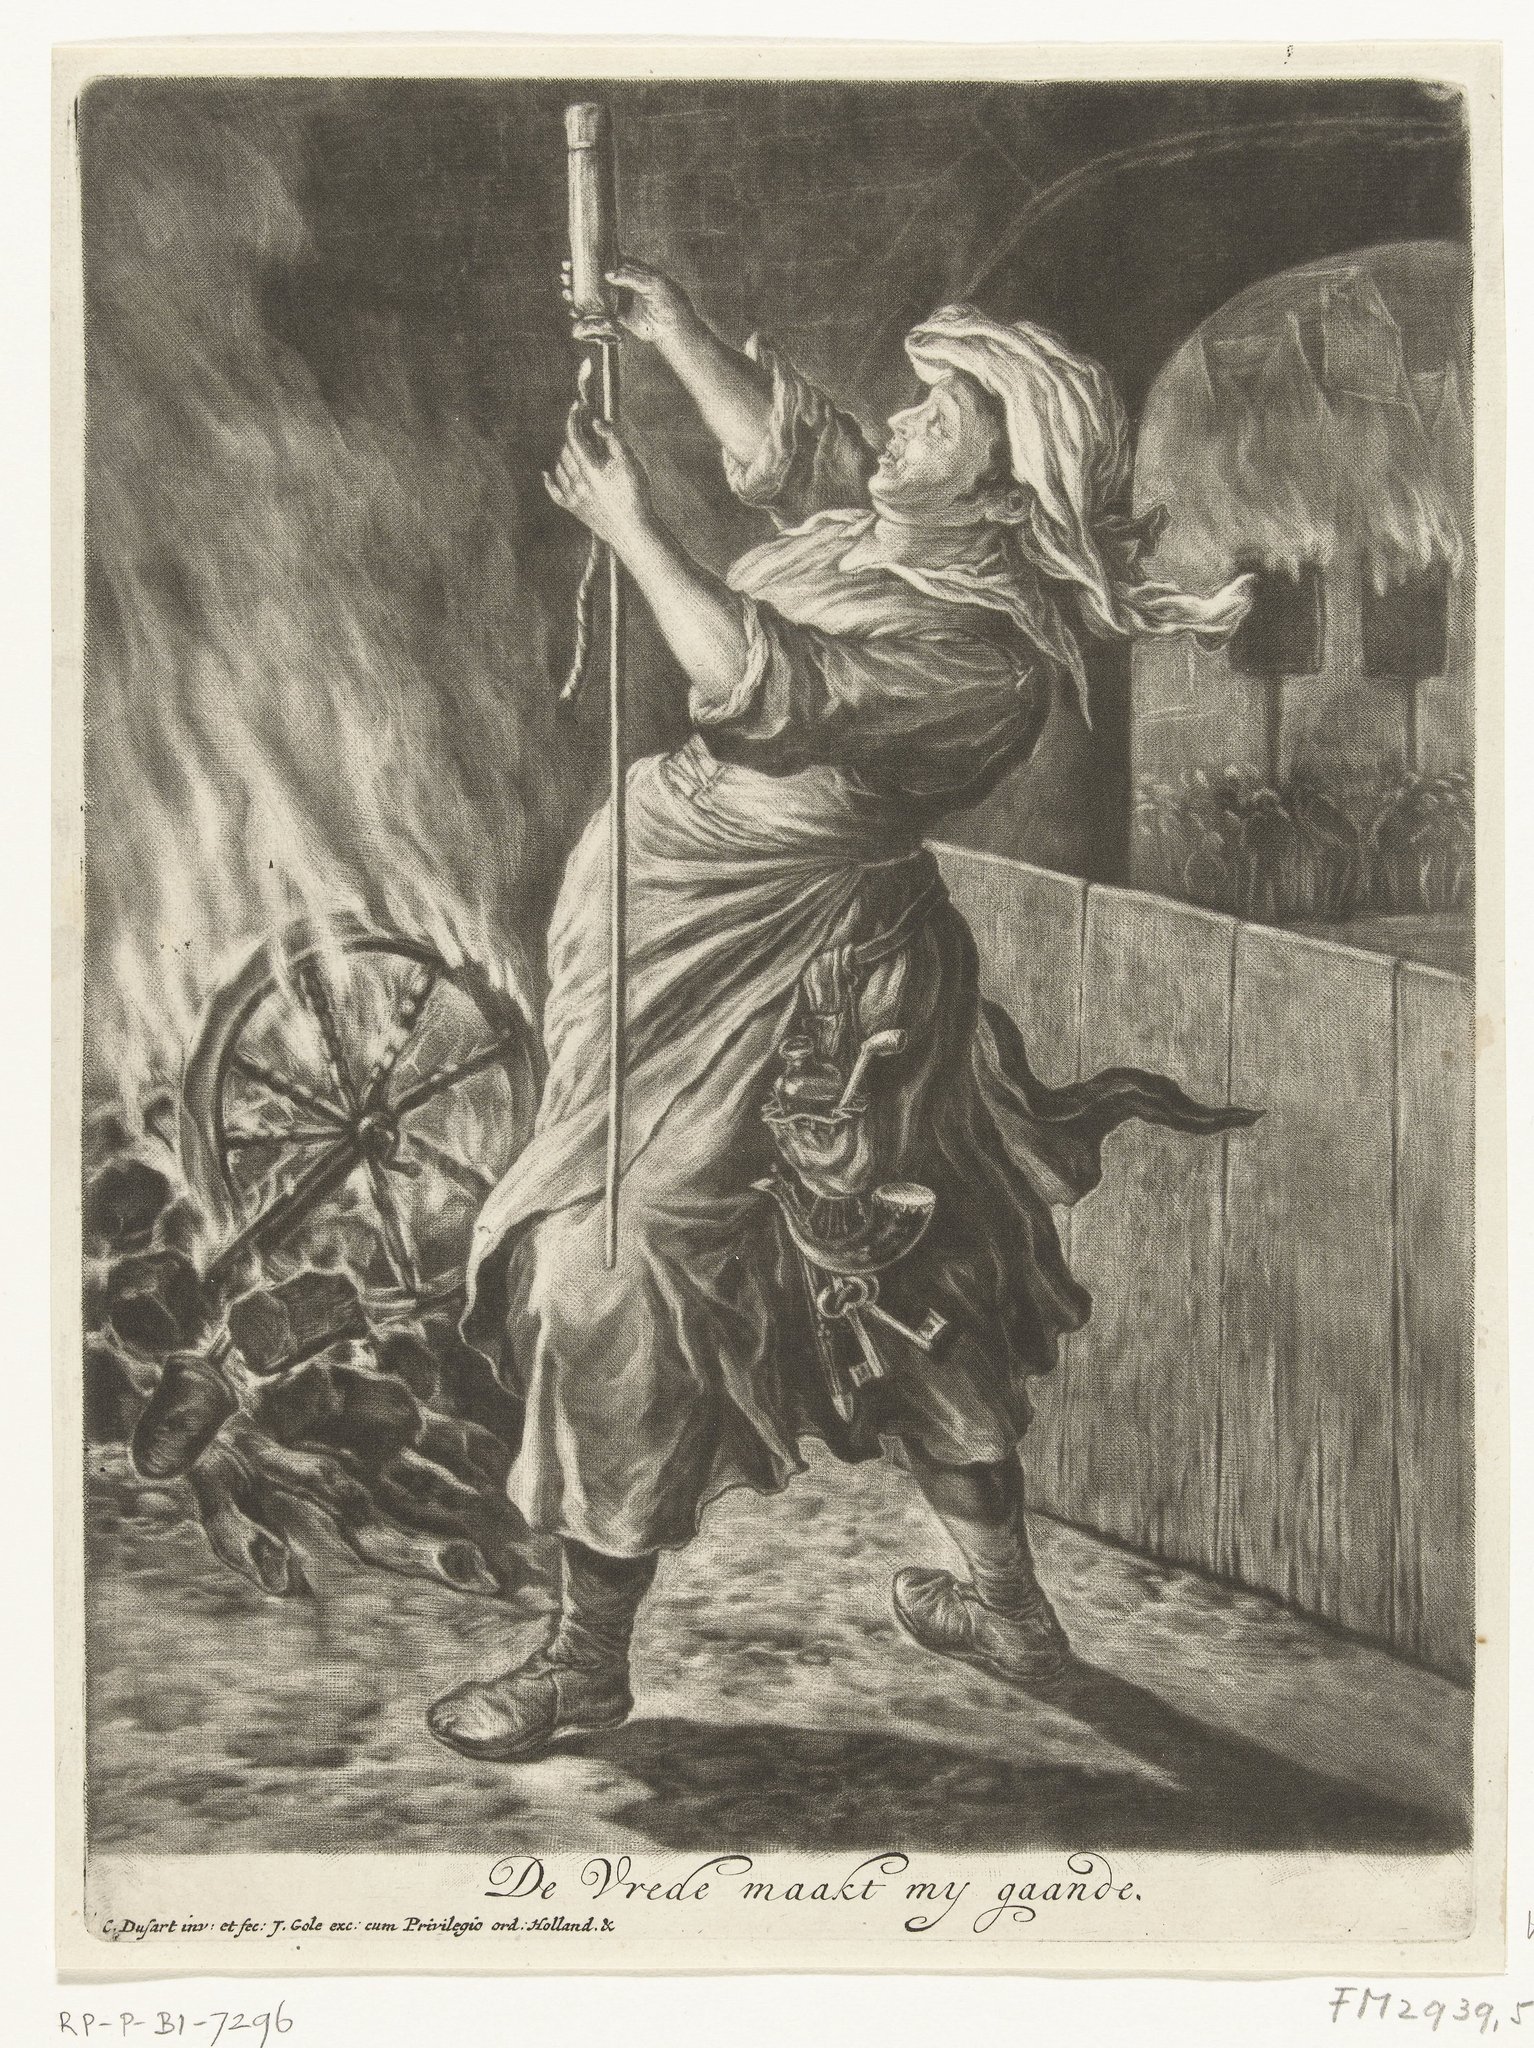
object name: print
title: De Vrede maakt mij gaande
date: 1695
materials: paper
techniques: mezzotint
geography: amsterdam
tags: the hague, william iii (prince of orange and king of england, scotland, and ireland), bonfire, fire-works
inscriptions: collector's mark: Lugt 240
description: Een vrouw steekt met een lont een vuurpijl aan, op de achtergrond meer vreugdevuren. Onderdeel van een reeks van acht prenten vervaardigd naar aanleiding van de verovering van Namen door de geallieerden onder koning Willem III op 5 september 1695.